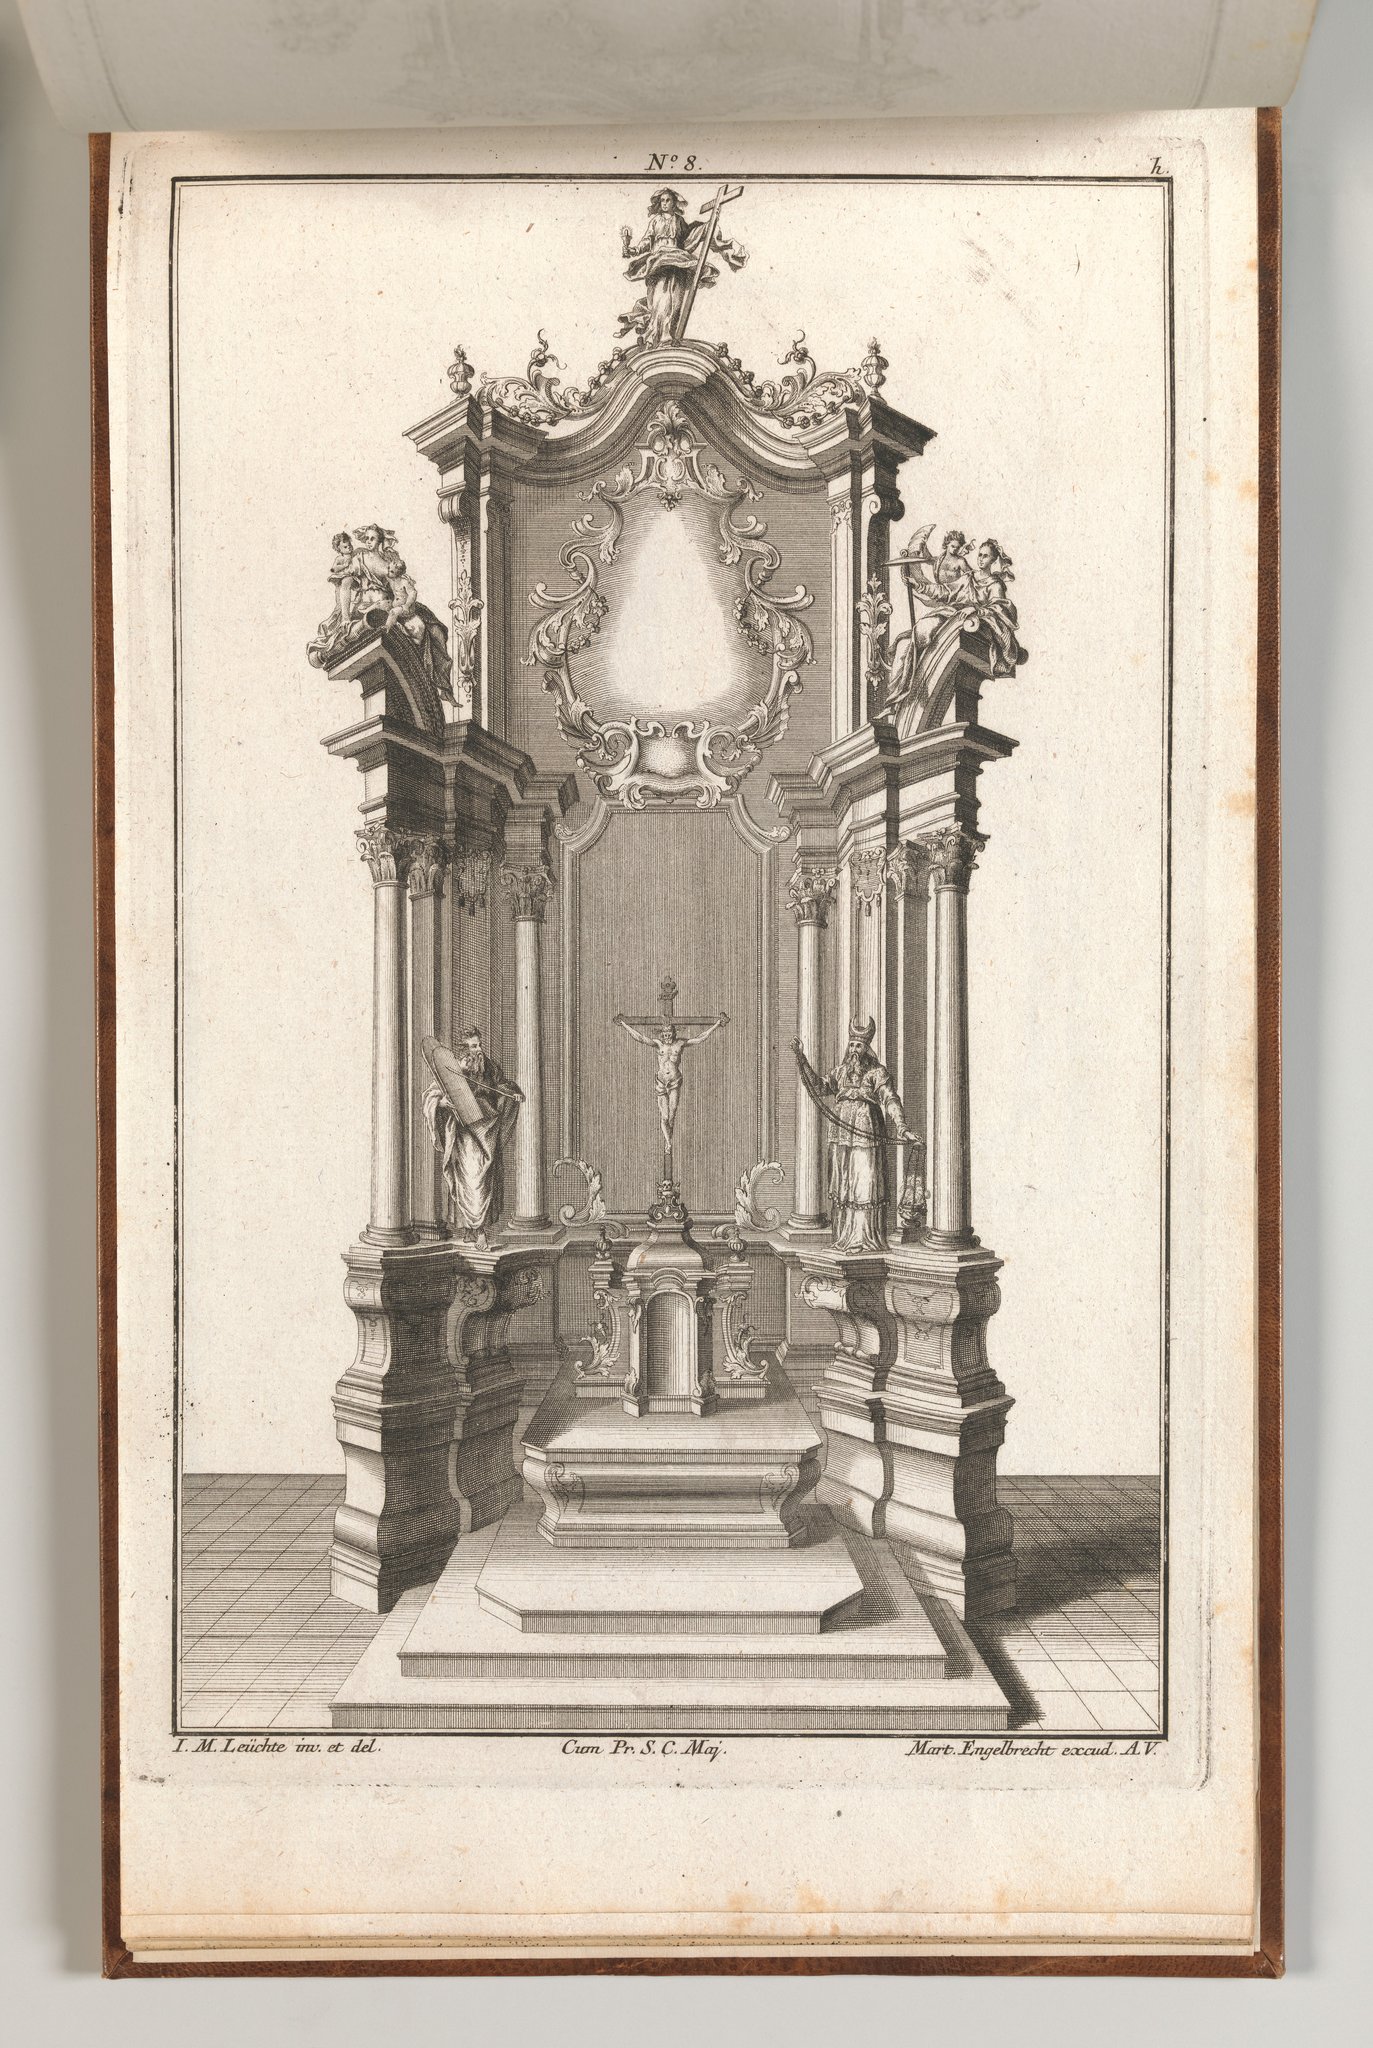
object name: album print ornament architecture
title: Design for a Monumental Altar, Plate h from 'Unterschiedliche Neu Inventierte Altäre mit darzu gehörigen Profillen u. Grundrißen.'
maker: johann michael leüchte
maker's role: artist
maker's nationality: german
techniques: etching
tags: altars,mothers,christ,moses,crucifixion